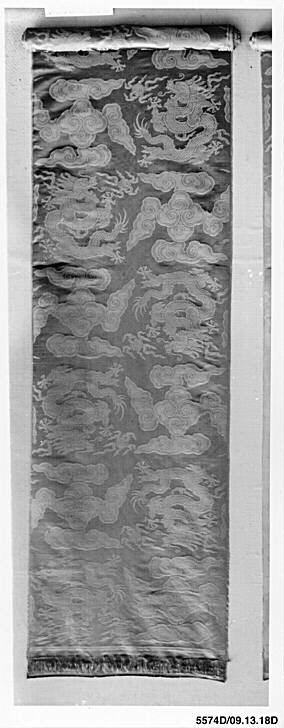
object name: do not use this record duplicate of 09. 13. 18a d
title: Piece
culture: chinese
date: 1801-1900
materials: silk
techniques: weave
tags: dragons